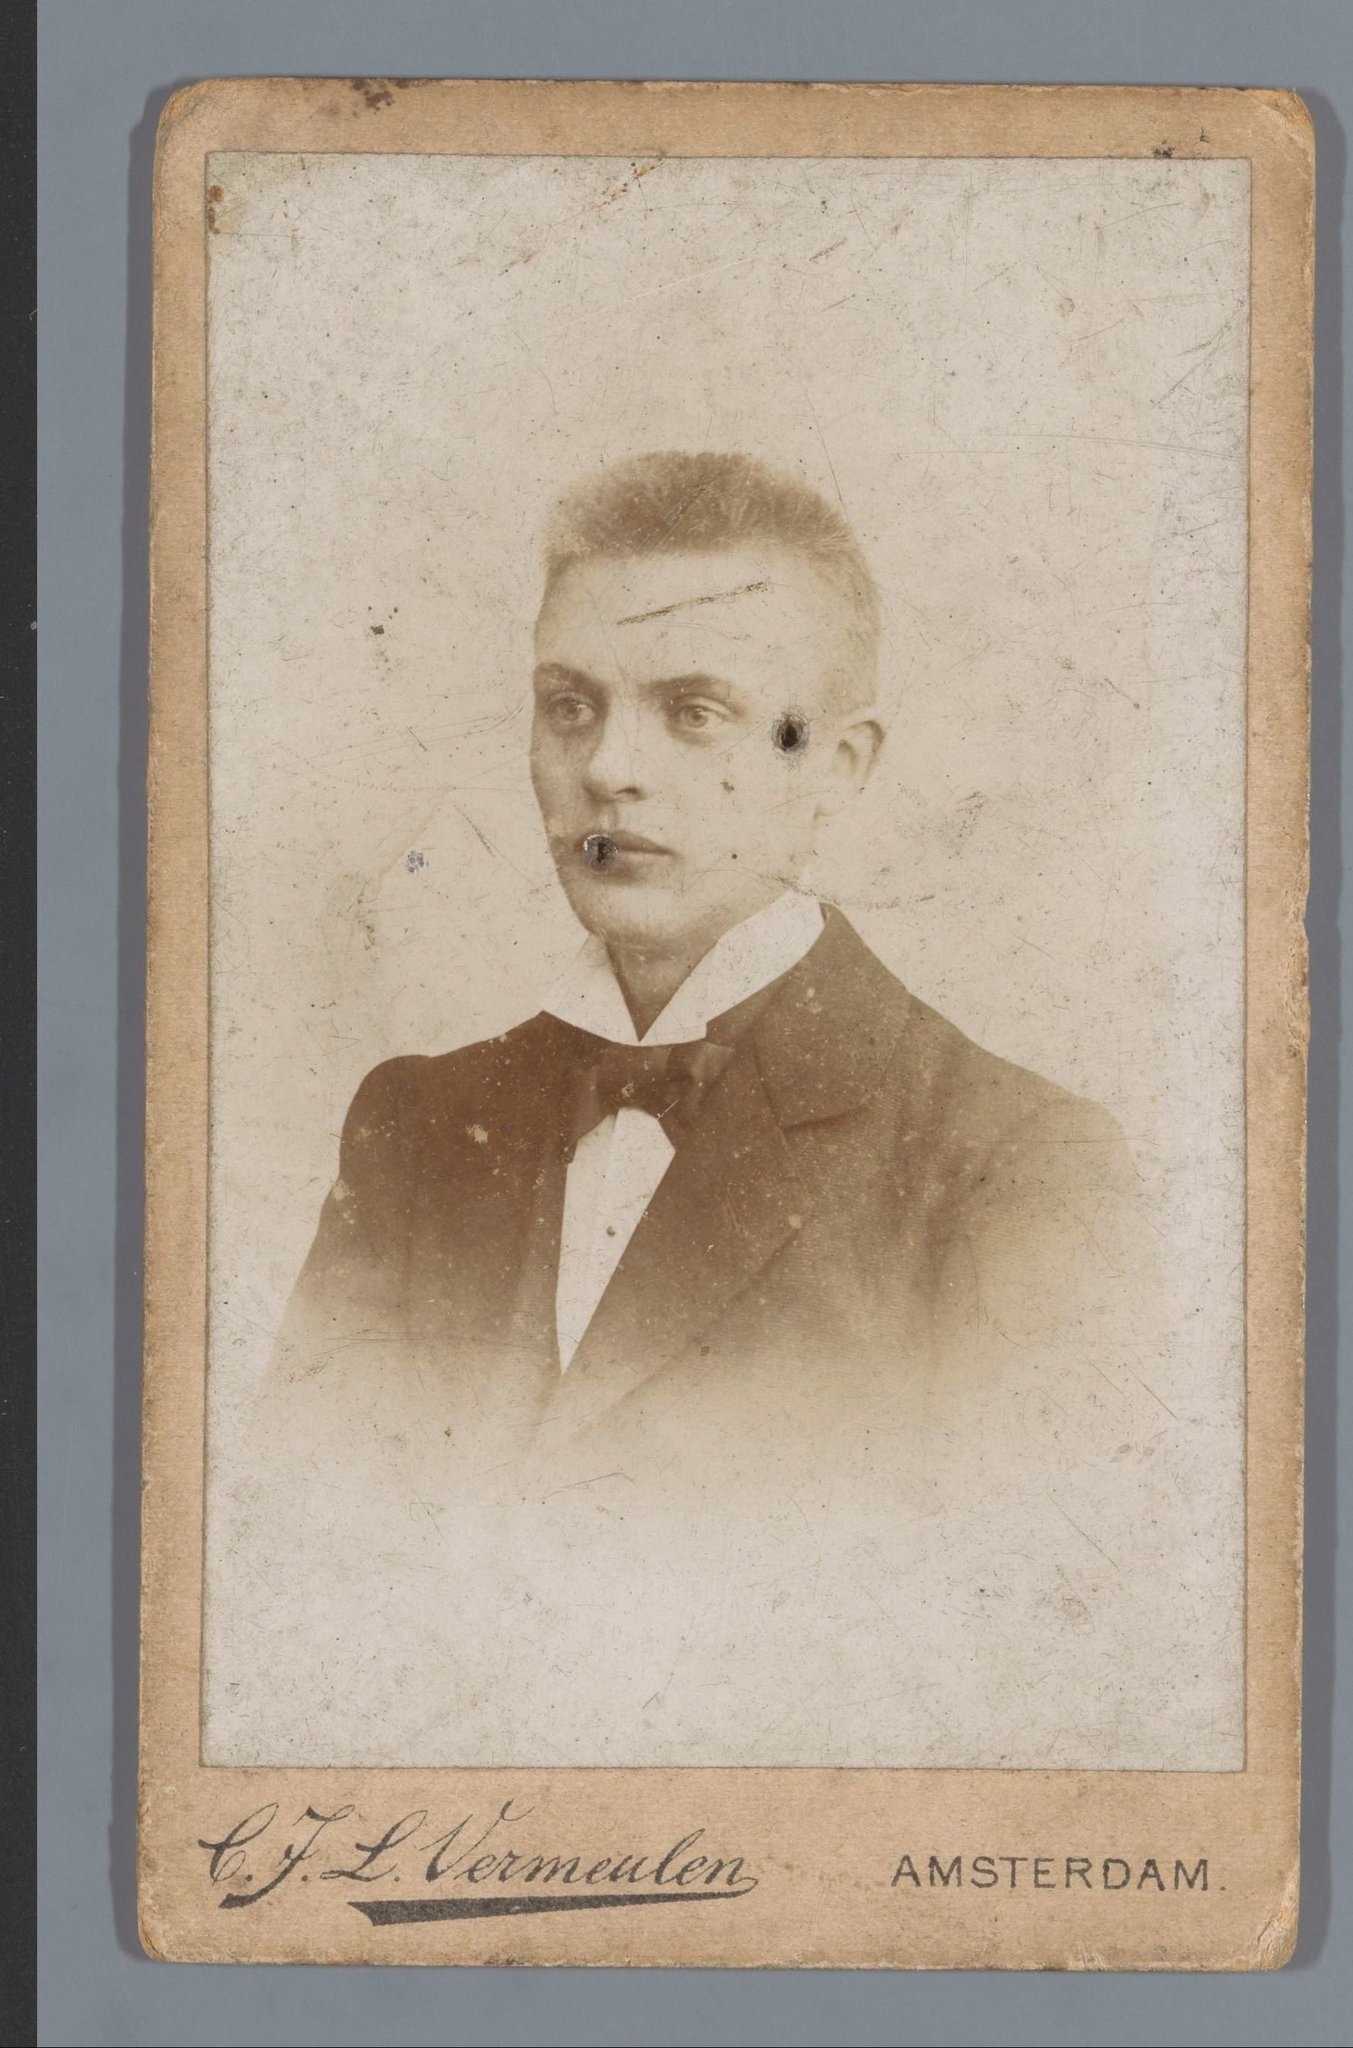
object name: carte de visite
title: Portret van een onbekende man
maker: cornelis johannes lodewicus vermeulen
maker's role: fotograaf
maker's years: 1861-1936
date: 1878-1896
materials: cardboard, paper, photographic support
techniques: gelatin silver print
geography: amsterdam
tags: adult man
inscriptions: name: ‘C.J.L. Vermeulen Amsterdam’, inscription: ‘C.J.L. Vermeulen [...]’